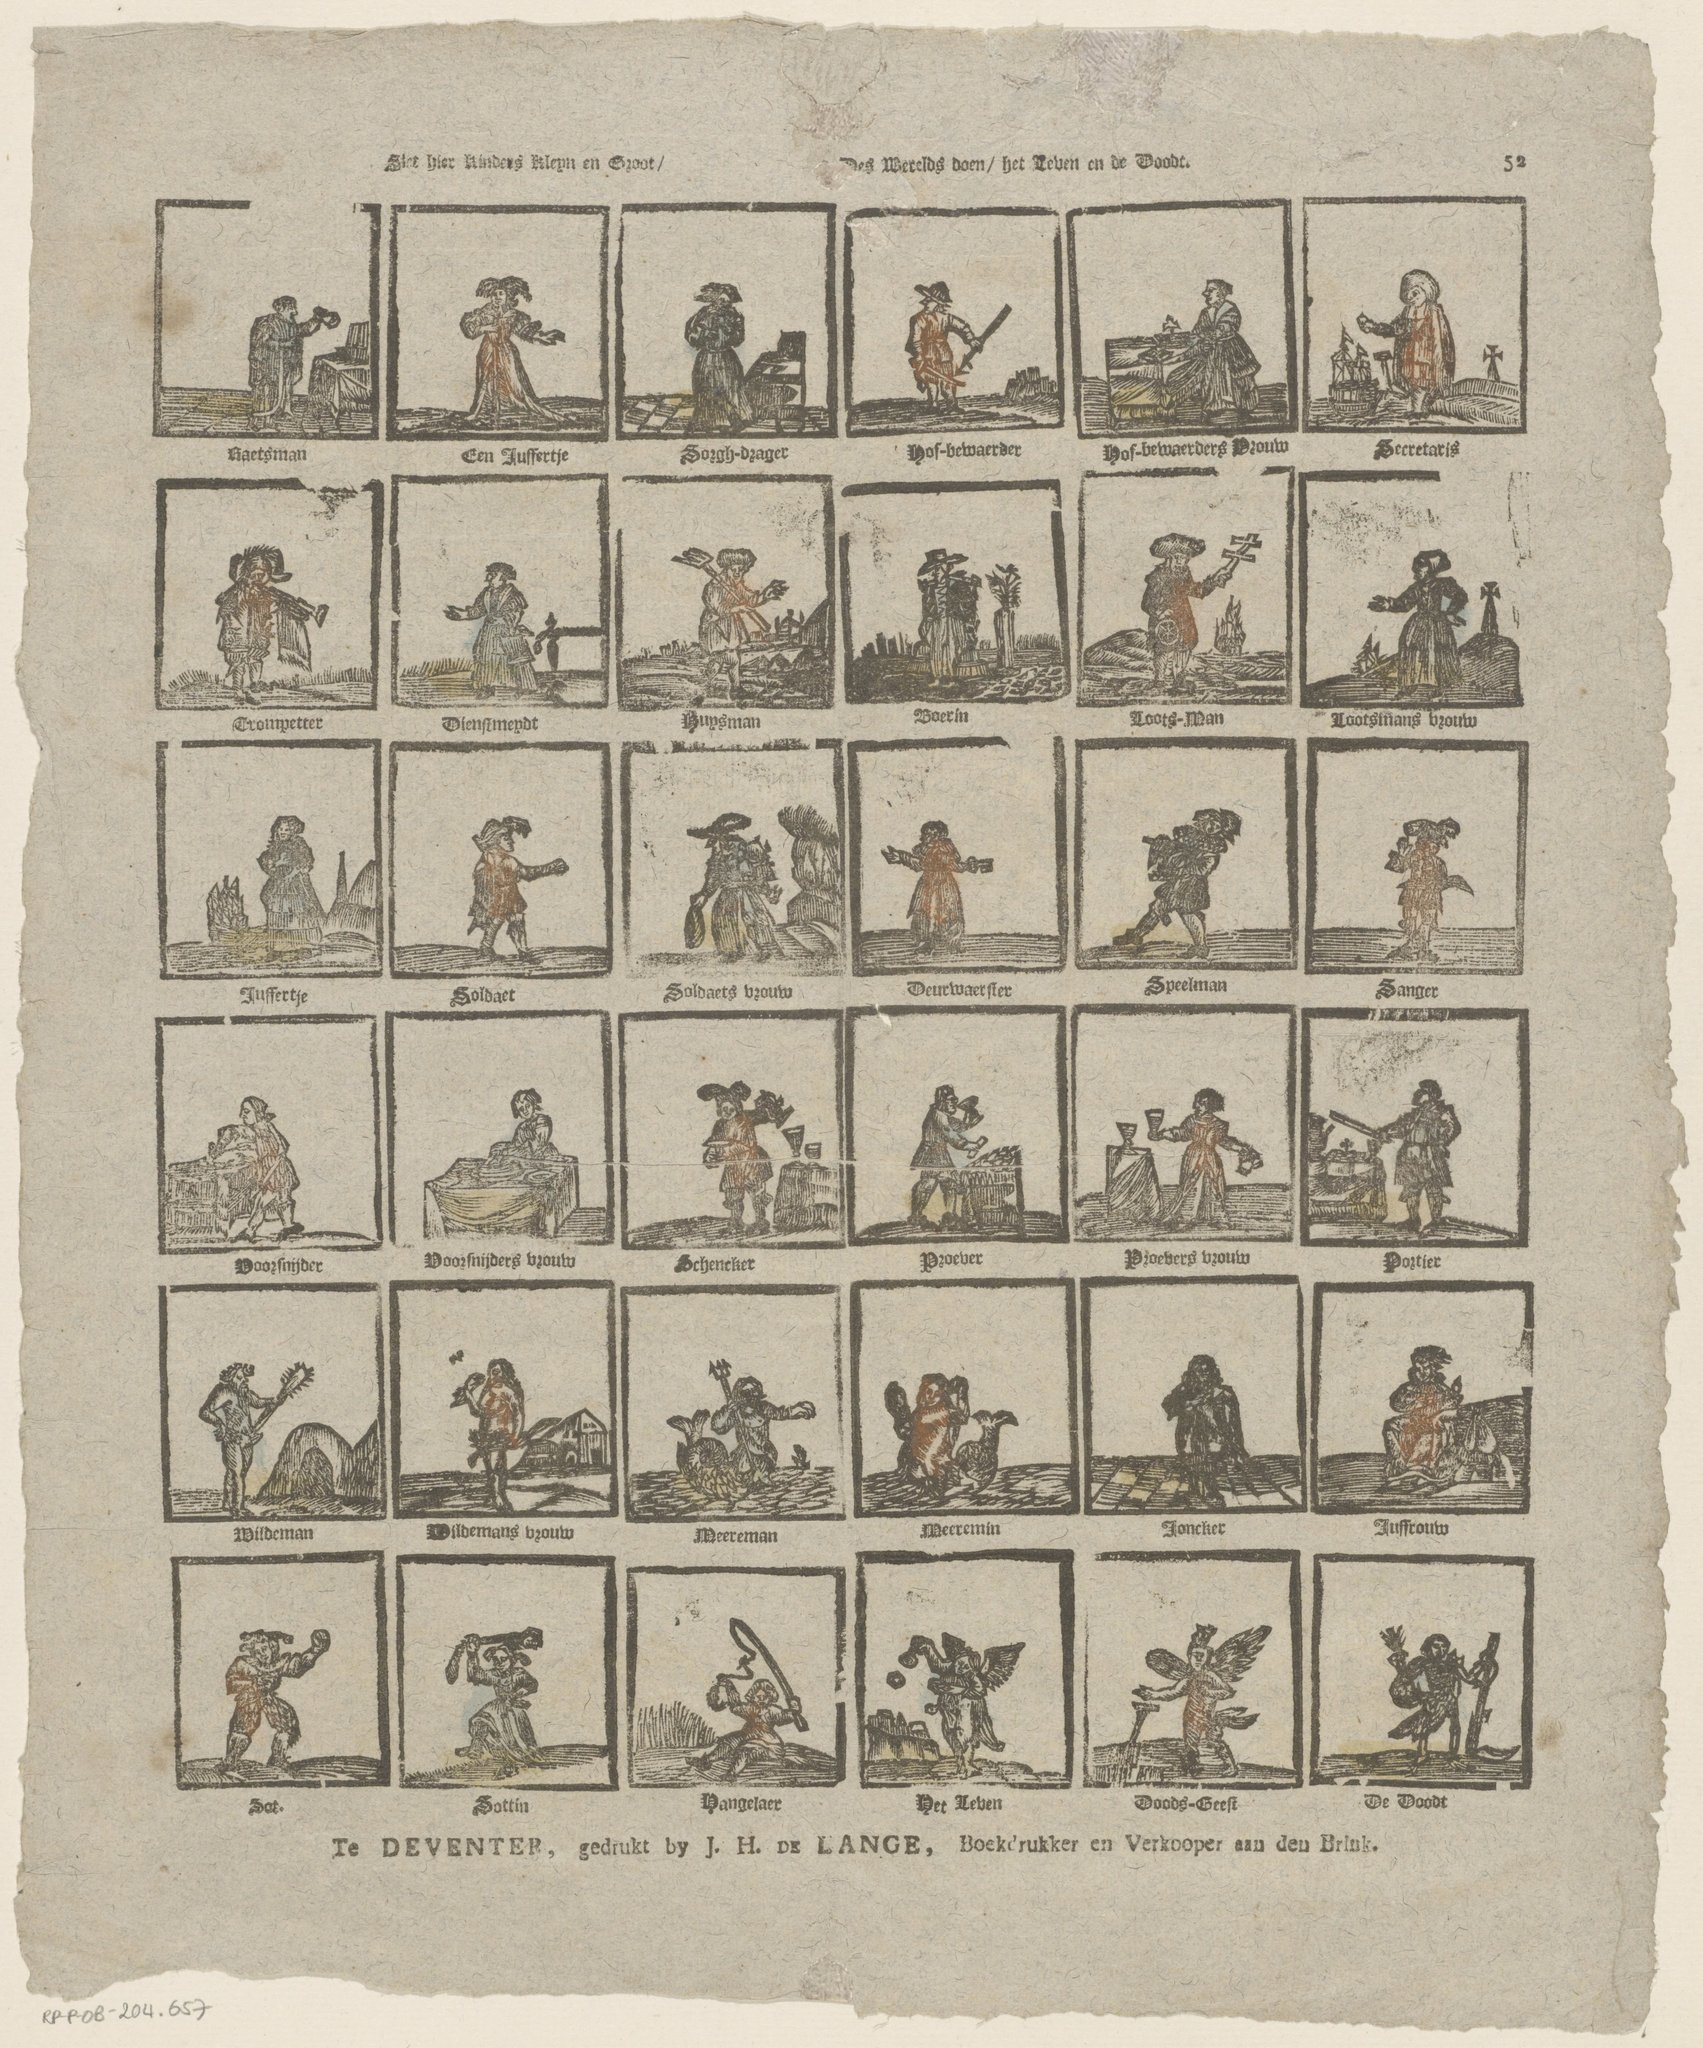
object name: popular print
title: Floskaartjes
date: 1787-1822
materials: paper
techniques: colour, letterpress printing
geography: netherlands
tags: symbols and personifications of death, social position, playing-cards, nobility and patriciate; chivalry, knighthood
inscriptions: collector's mark: Lugt 2760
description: Blad met 36 speelkaarten (floskaartjes) met voorstellingen van figuren met verschillende beroepen en maatschappelijke posities. De laatste afbeelding toont de dood. Onder elke voorstelling een onderschrift. Genummerd rechtsboven: No. 52.